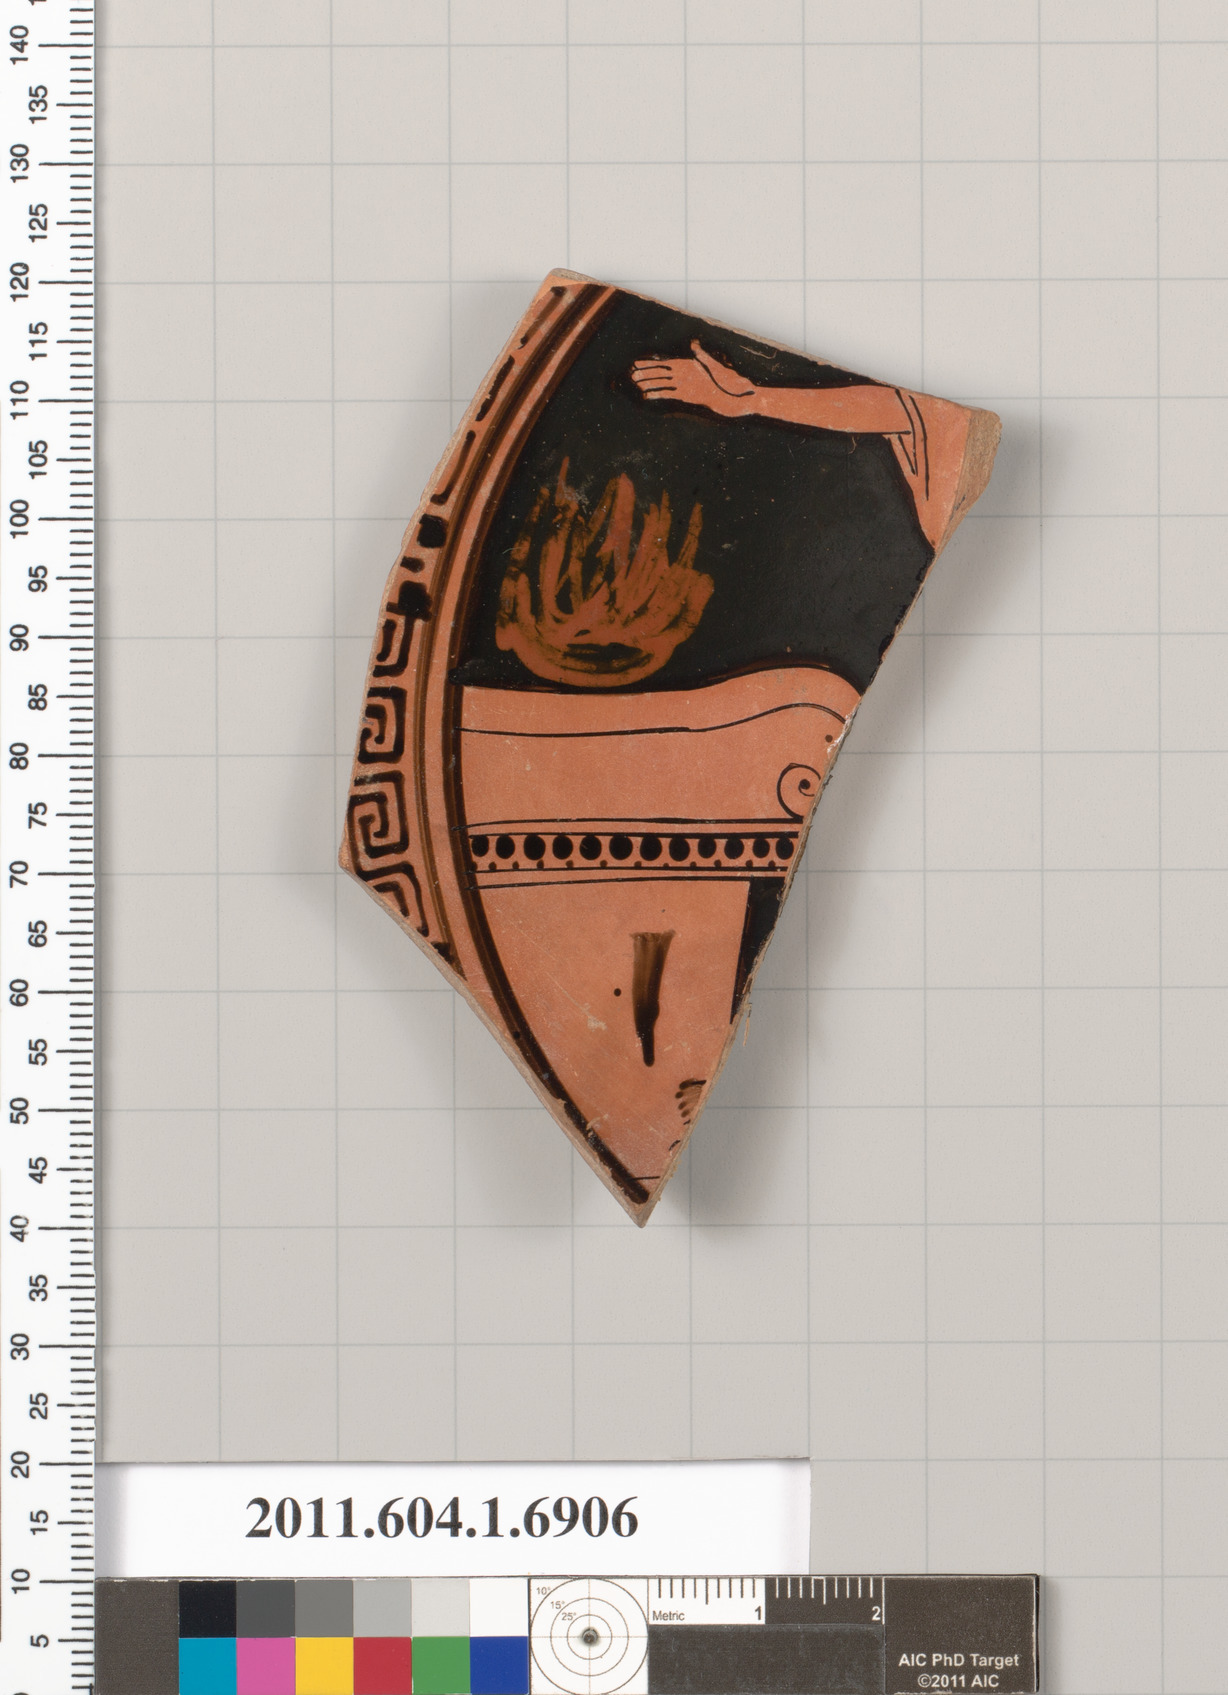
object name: kylix fragment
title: Terracotta fragment of a kylix (drinking cup)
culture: greek, attic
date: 490-470 BCE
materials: terracotta